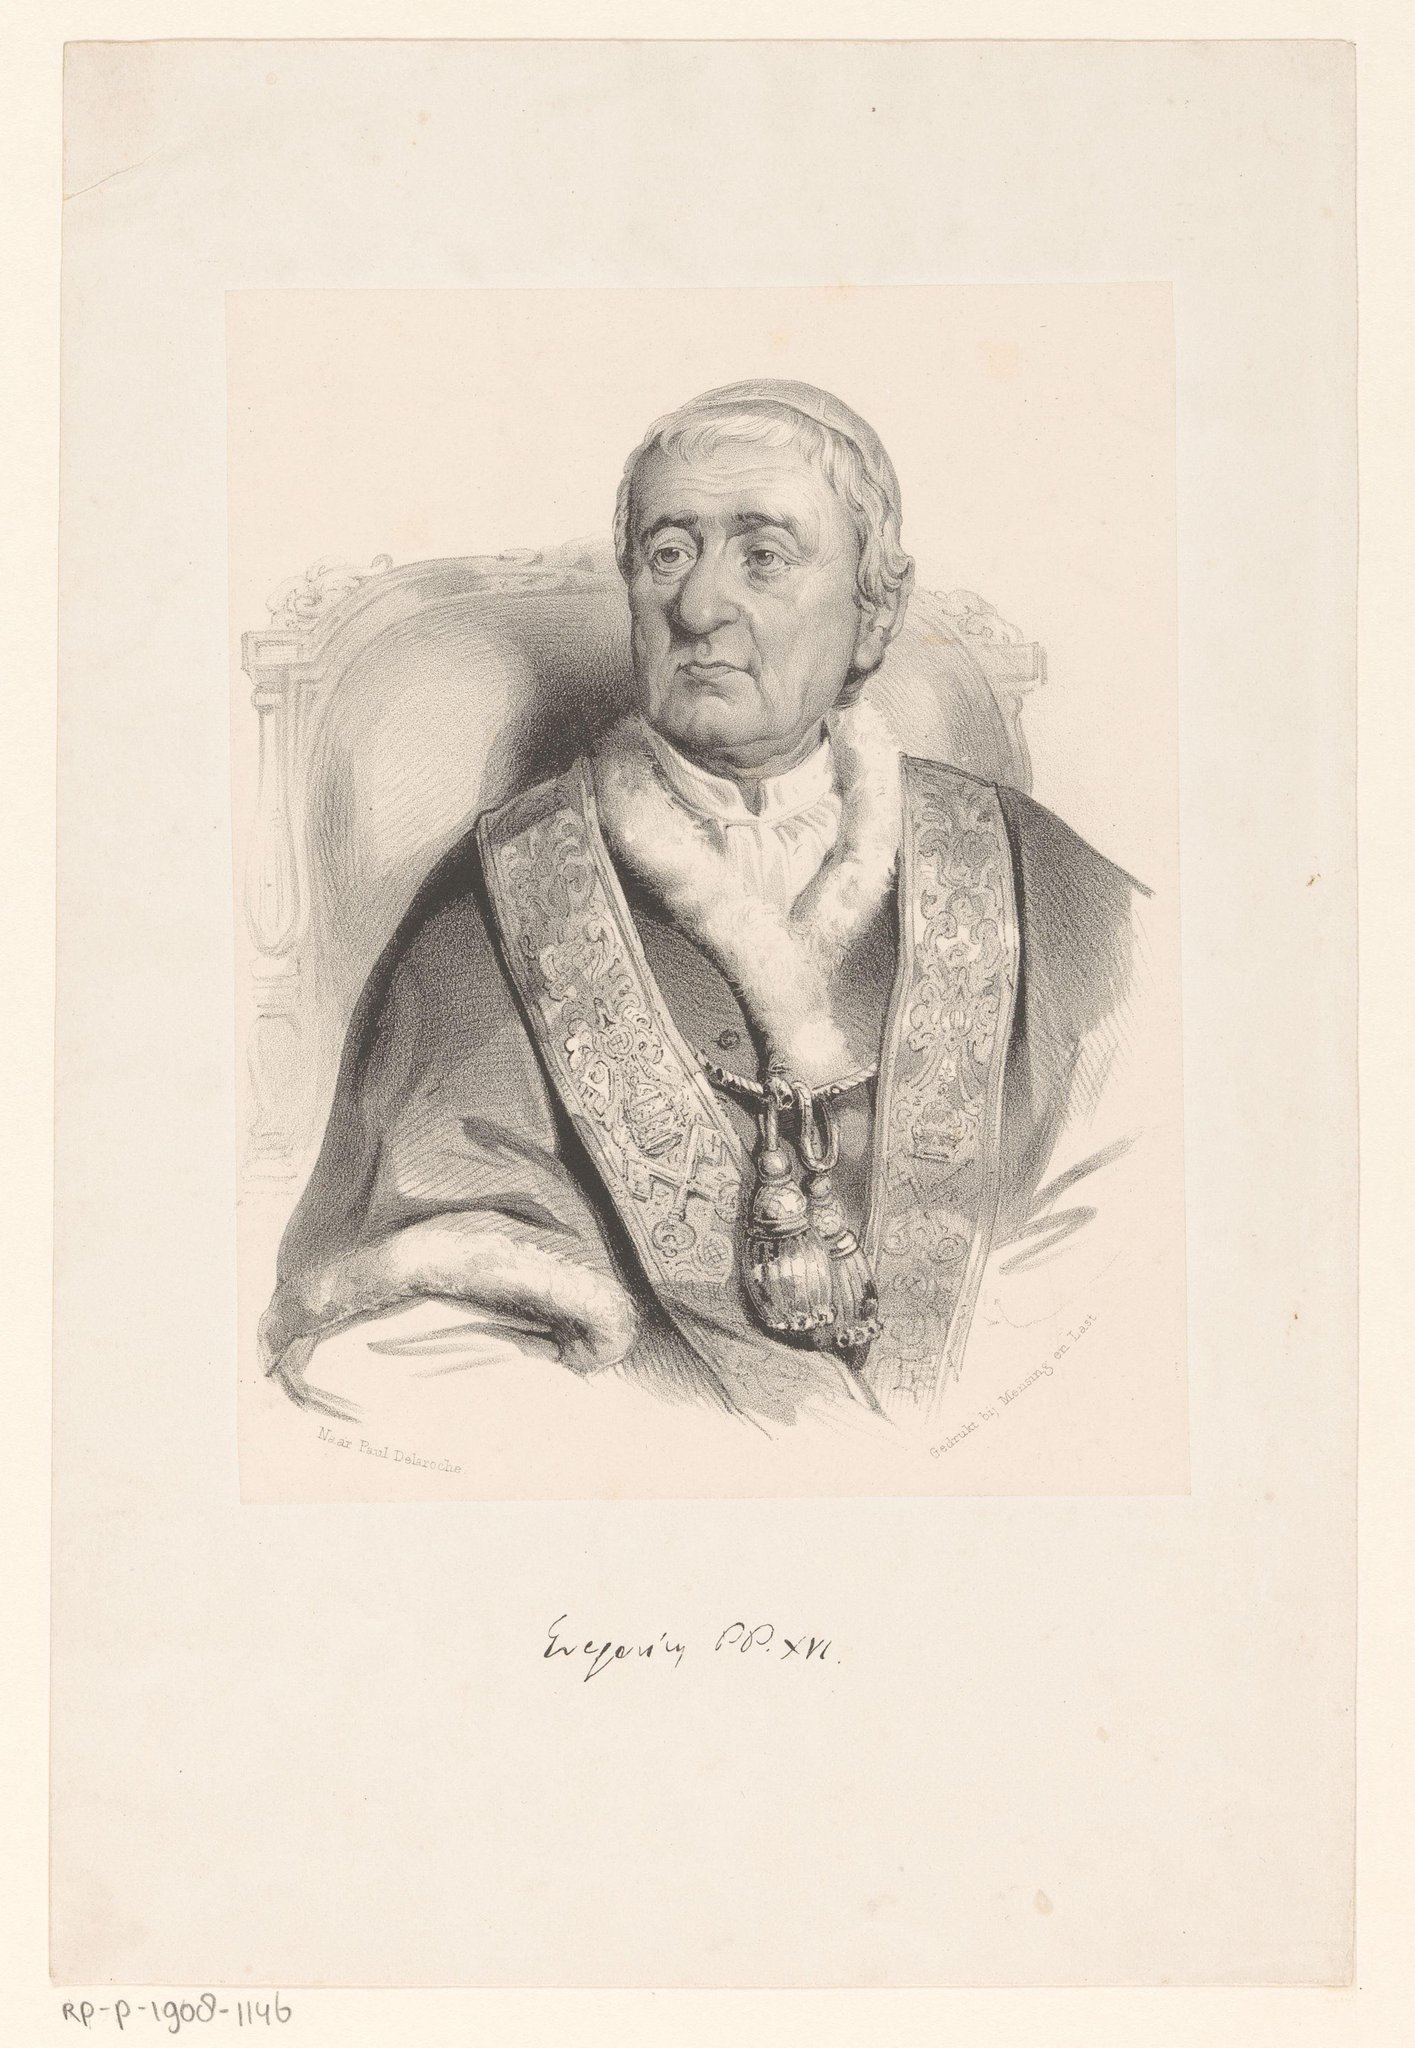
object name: print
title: Portret van paus Gregorius XVI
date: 1841-1847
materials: paper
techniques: lithograph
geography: netherlands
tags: rome, historical persons (+ (full) bust portrait)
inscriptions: collector's mark: Lugt 2228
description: De geportretteerde zit op een stoel en kijkt naar links. Hij draagt zijn ambtsgewaad, afgezet met bont en een stola.